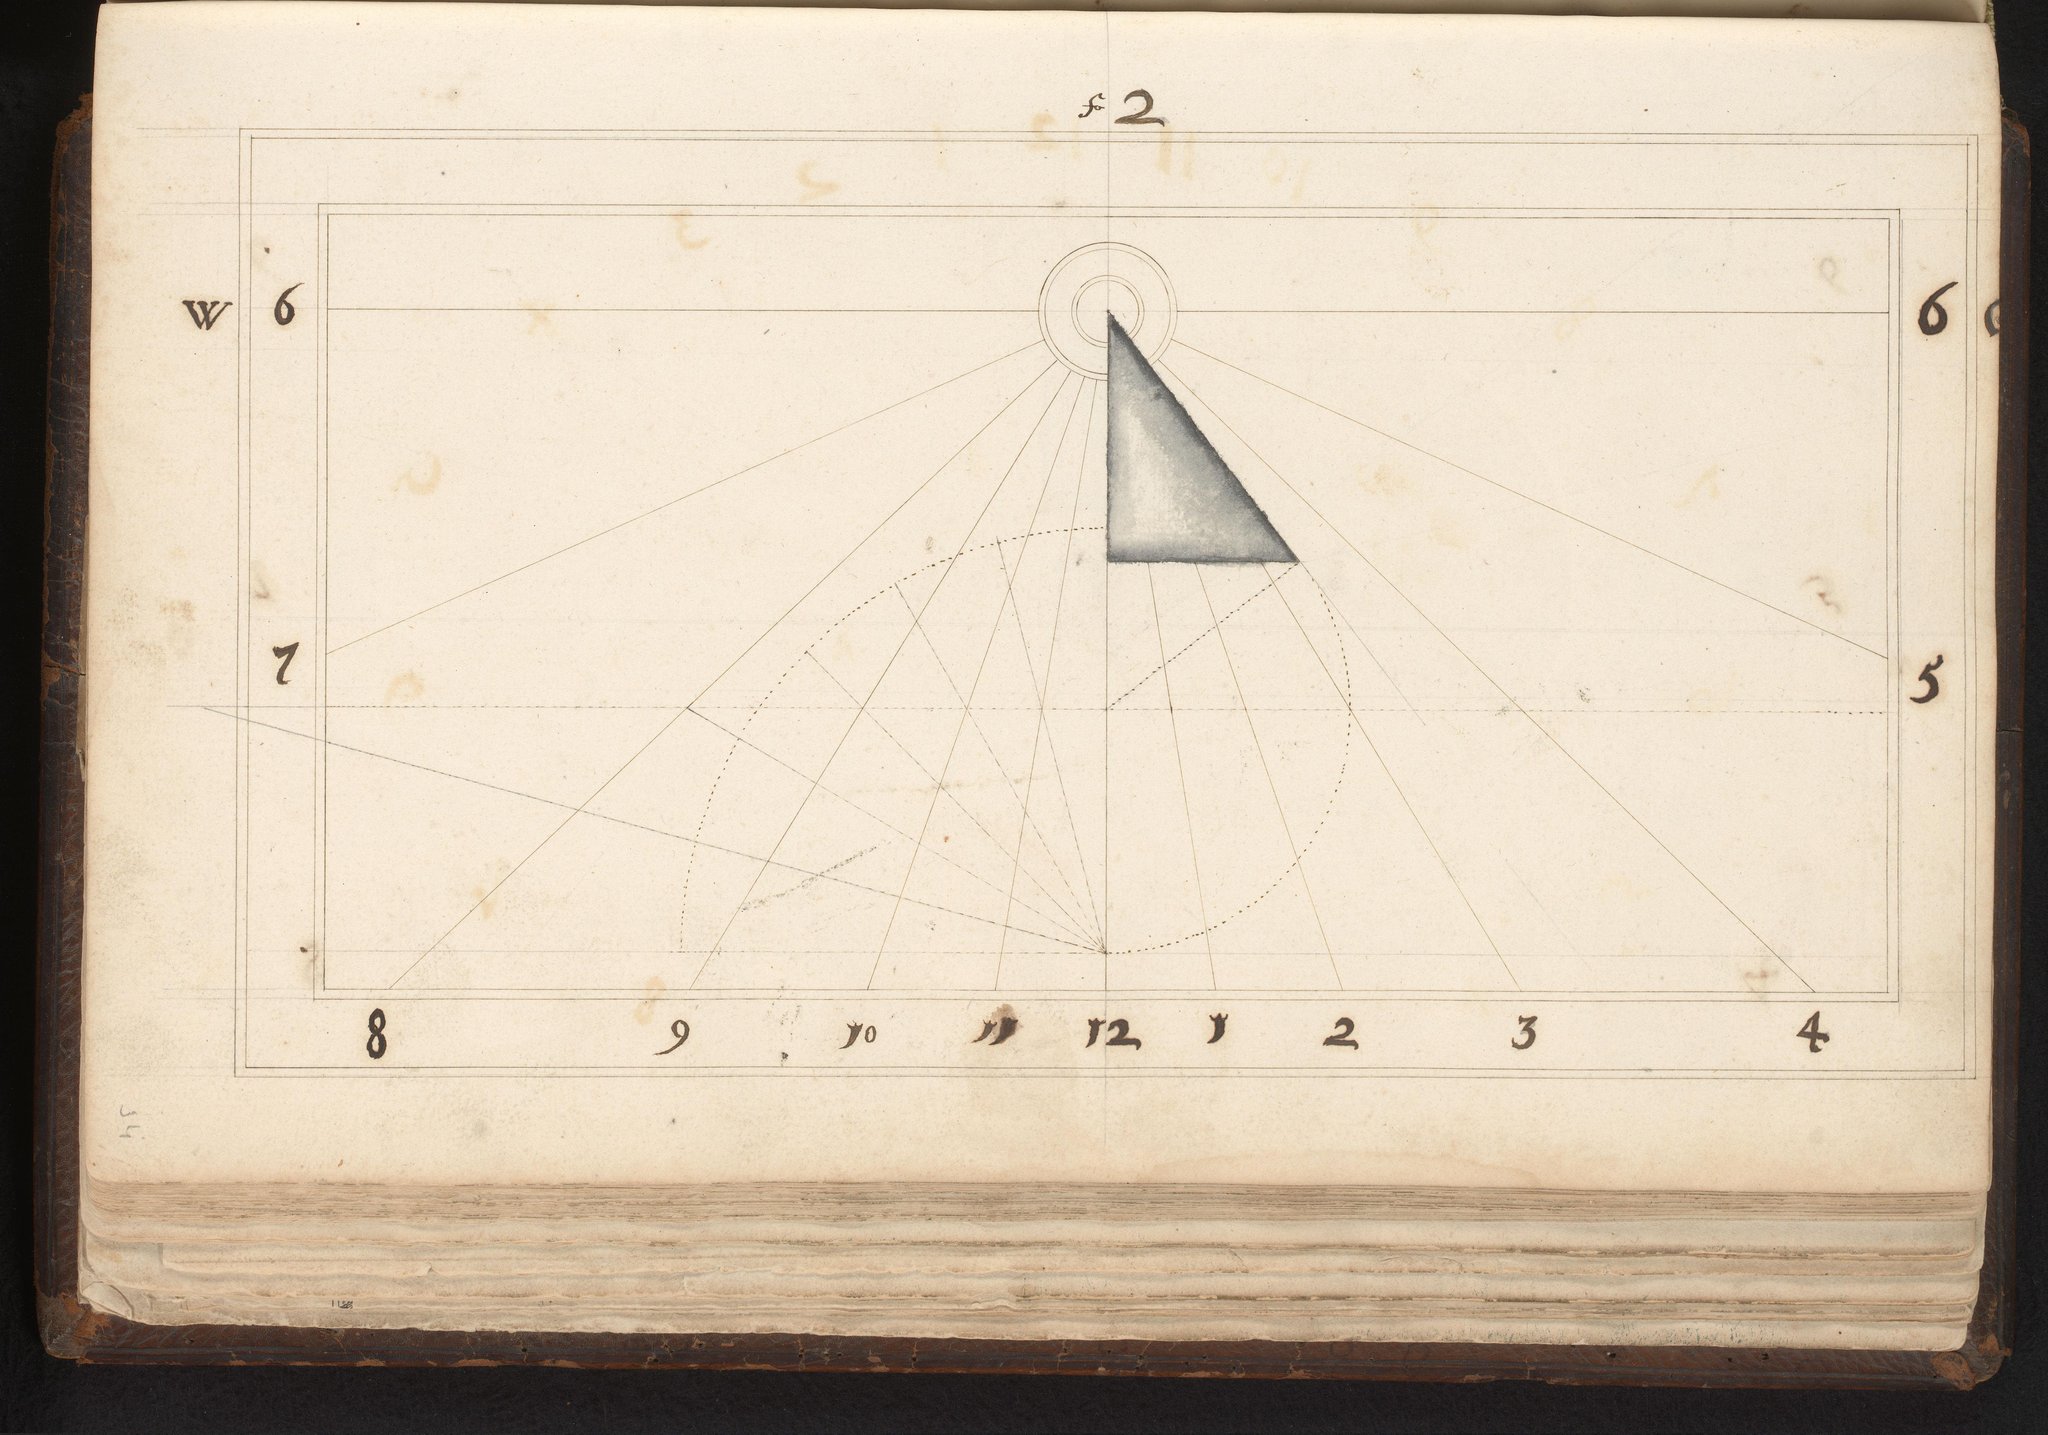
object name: drawing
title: Ontwerp voor een zonnewijzer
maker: Anonymous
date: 1650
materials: ink, paper, pencil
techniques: brush, pen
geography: low countries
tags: sundial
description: Midden links genummerd: Fo 2. Tekening maakt deel uit van een album.